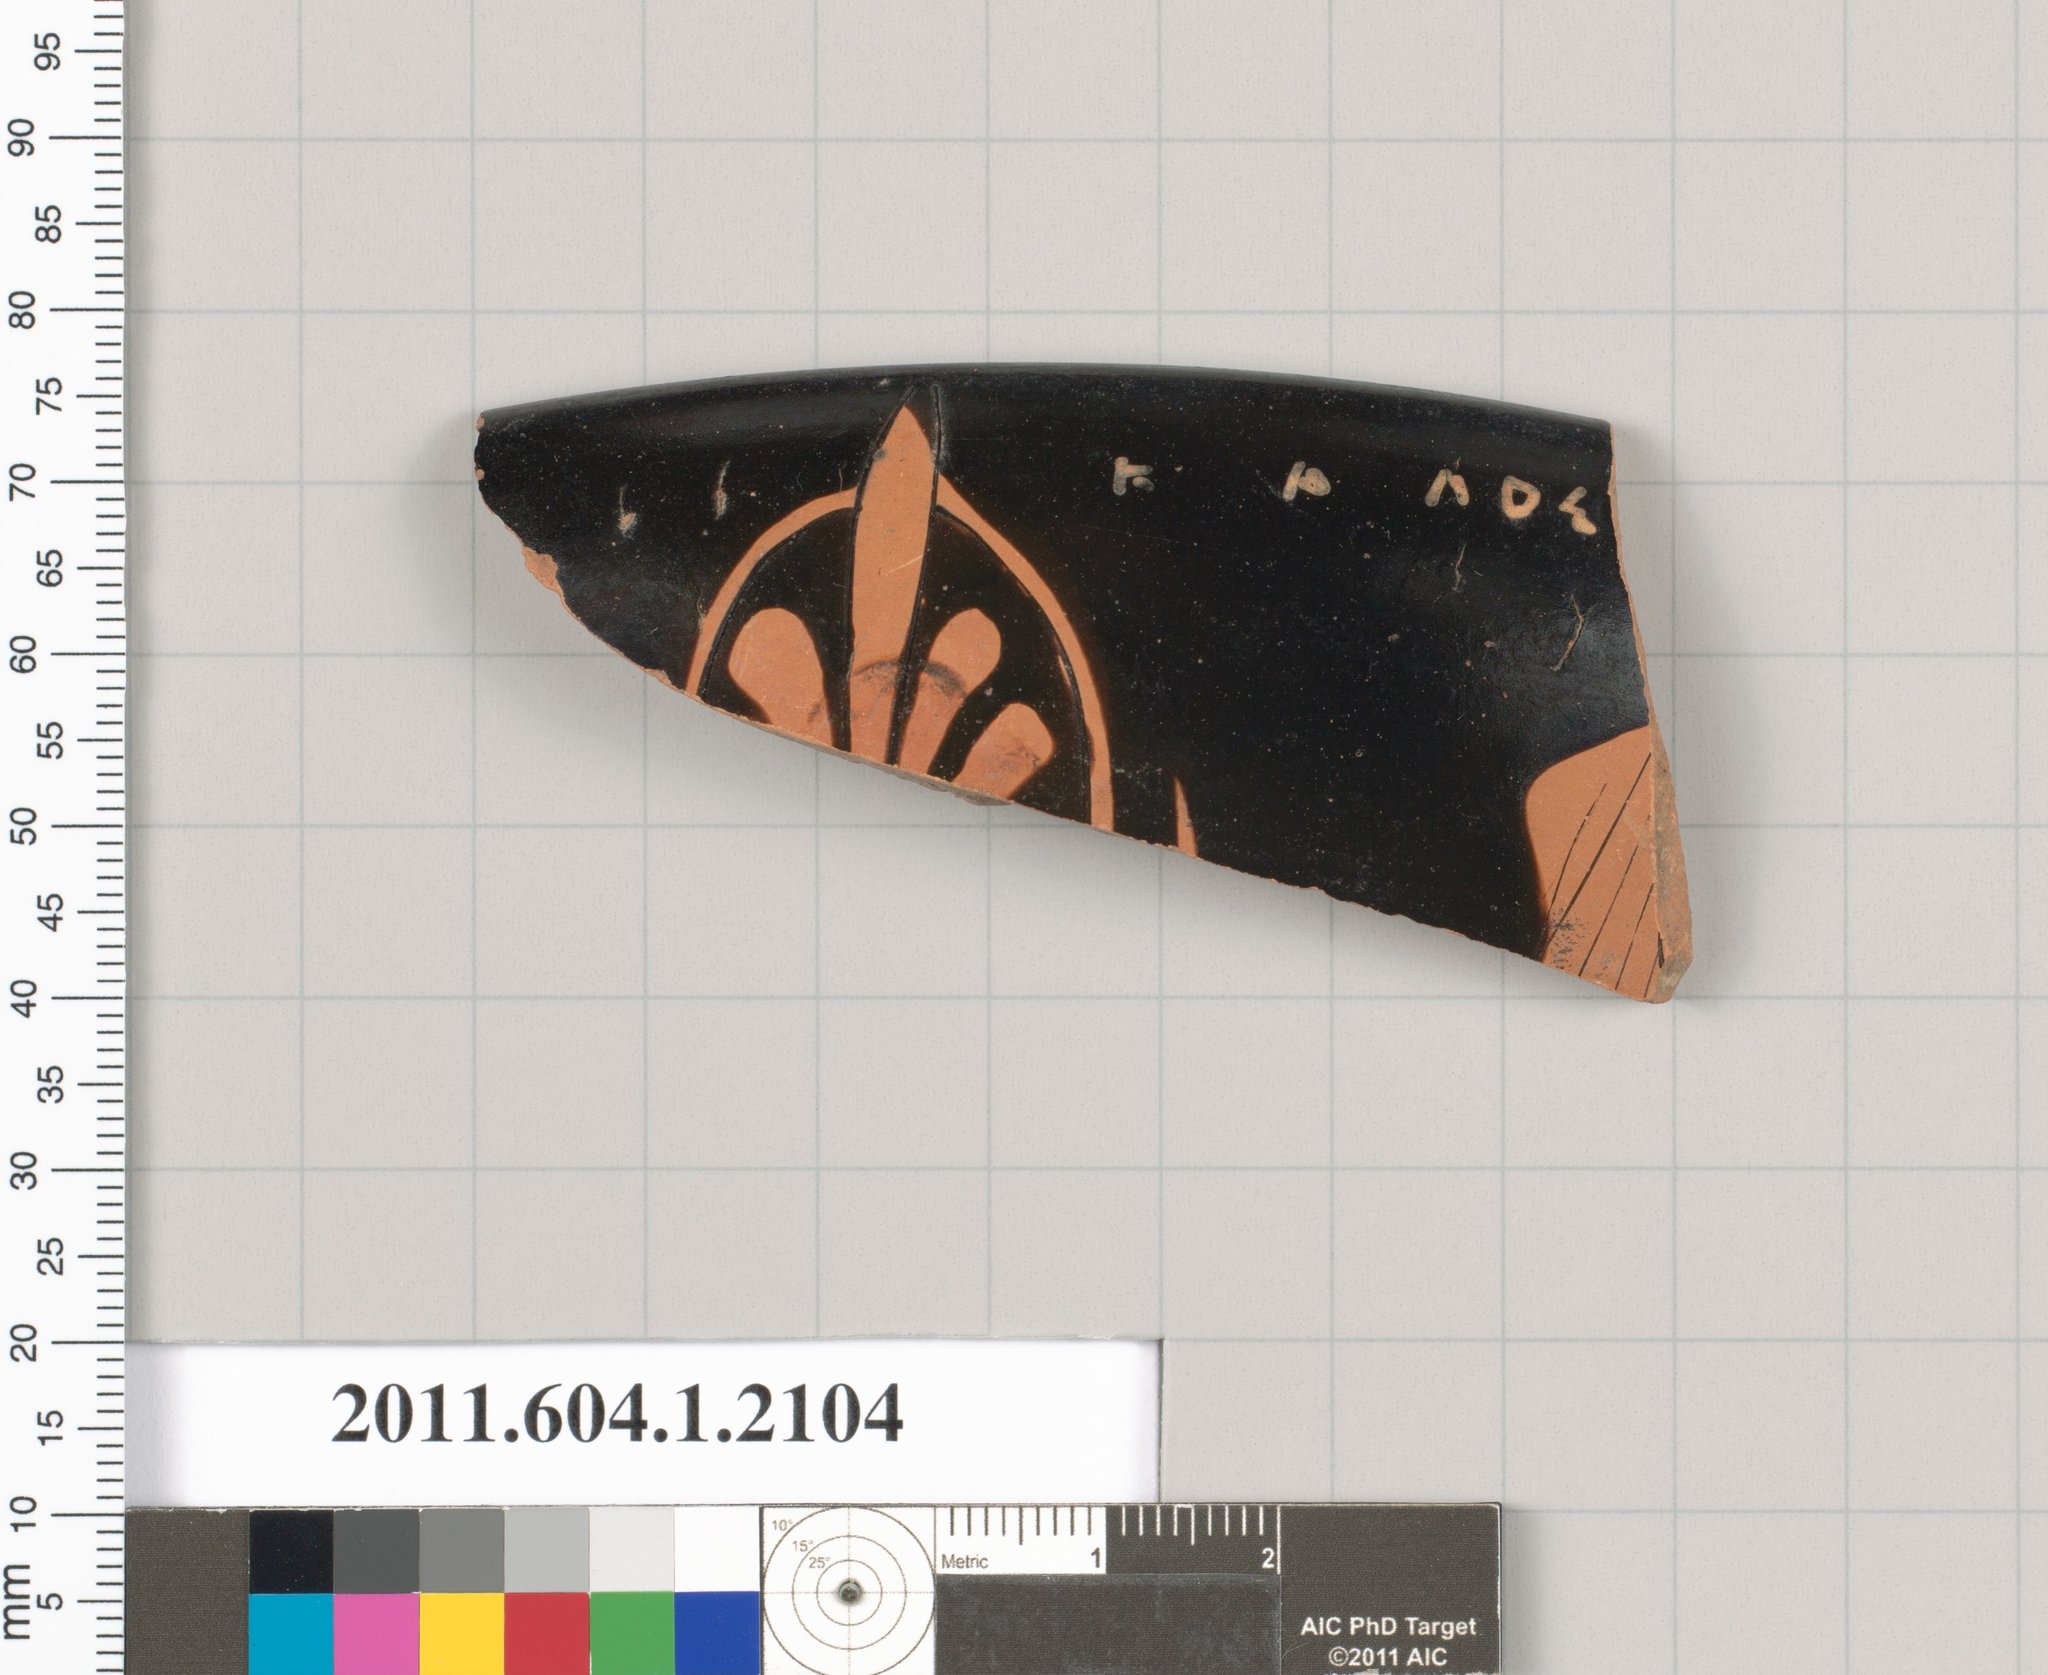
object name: kylix fragment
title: Terracotta rim fragment of a kylix (drinking cup)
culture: greek, attic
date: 475-451 BCE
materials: terracotta